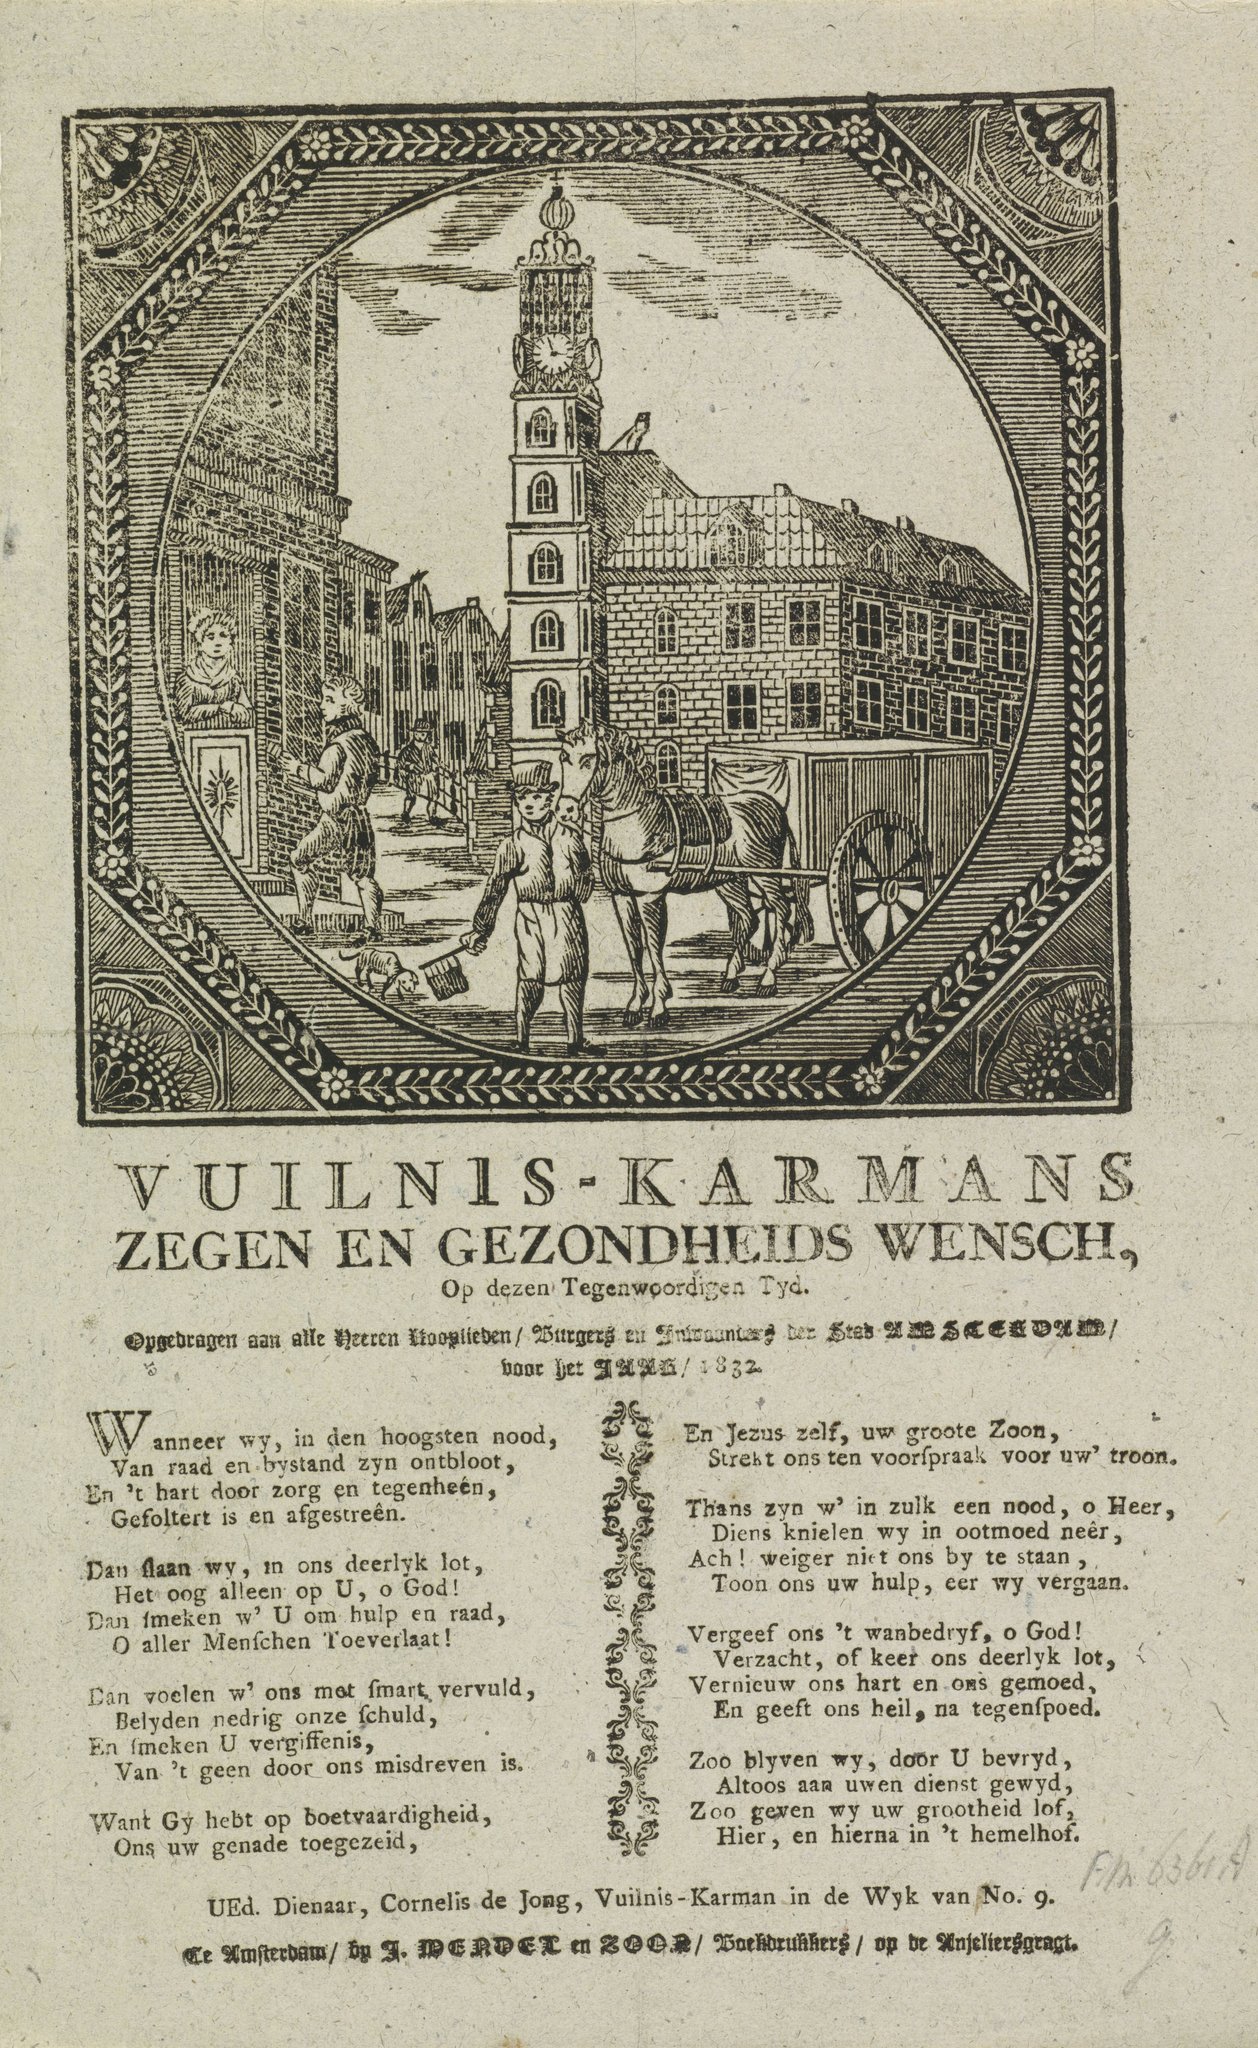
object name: new year card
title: Nieuwjaarswens van de vuilnismannen van Amsterdam voor het jaar 1832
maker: Anonymous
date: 1831-1832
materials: paper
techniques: letterpress printing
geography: amsterdam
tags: street, garbage collection, amsterdam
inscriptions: collector's mark: Lugt 2228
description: Nieuwjaarswens van de Amsterdamse vuilnismannen voor het jaar 1832. Ronde voorstelling binnen achtkantige rand met een gezicht bij de Munt te Amsterdam waar een man met een ratel bij een vuilniskar staat. Een andere man haalt bij een huis geld op. Met gedicht in twee kolommen en een lied in drie verzen. Van de vuilniskarman in de wijk no. 9: Cornelis de Jong.